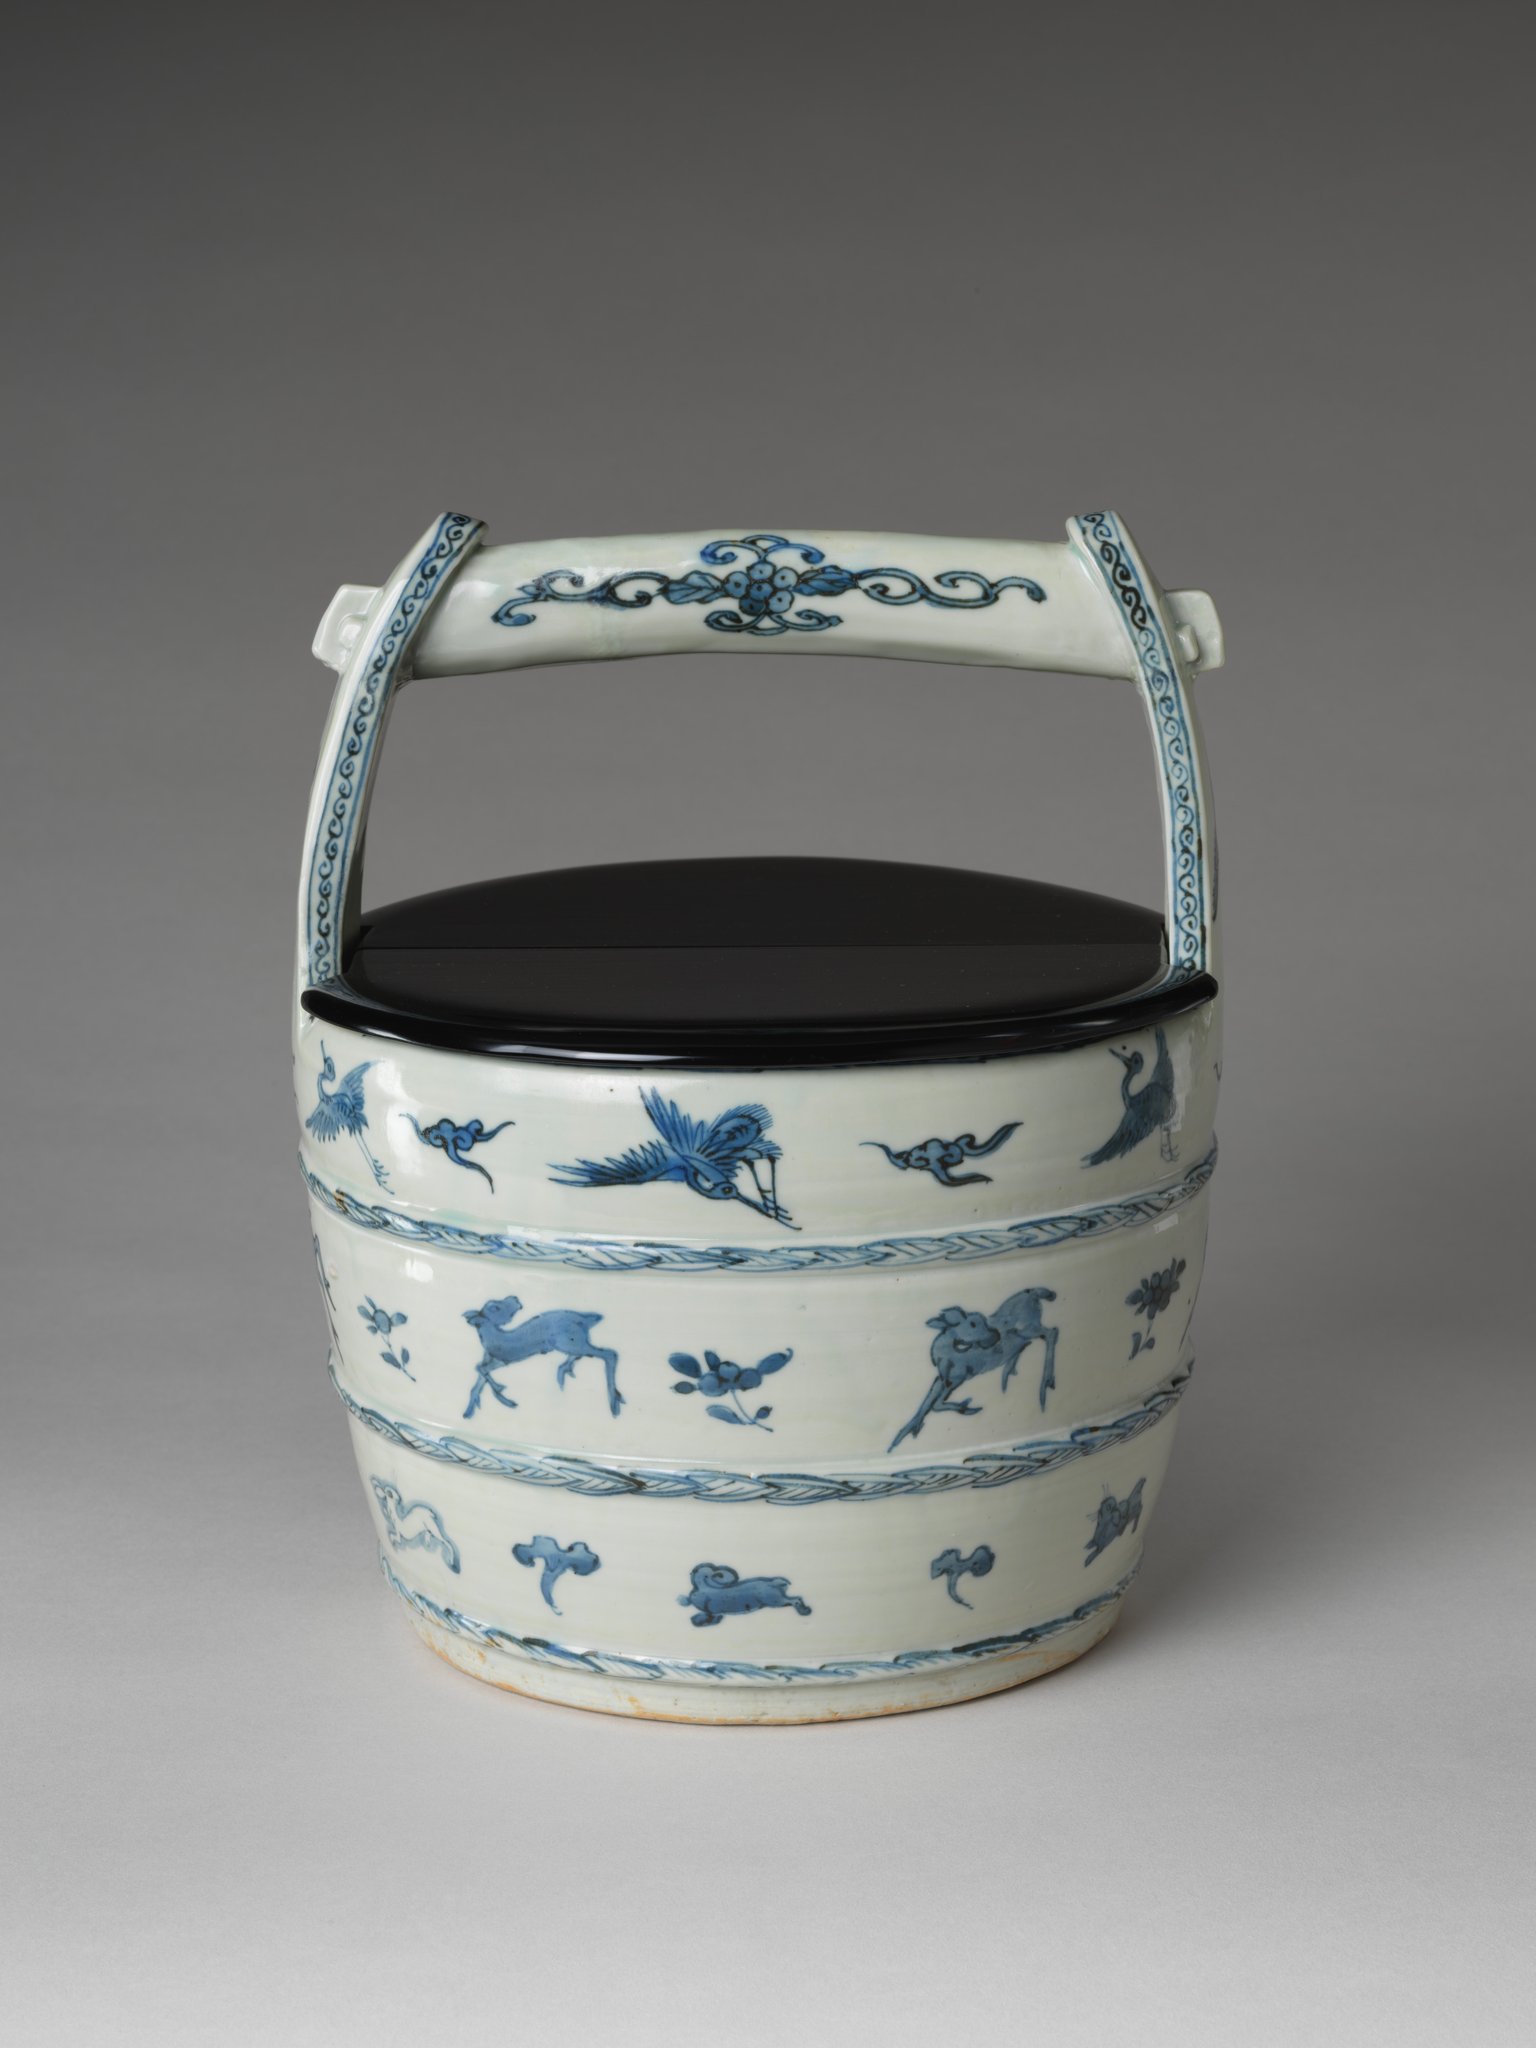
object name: freshwater jar mizusashi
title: Freshwater jar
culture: chinese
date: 1601-1633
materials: cobalt, glaze, porcelain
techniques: painting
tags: animals